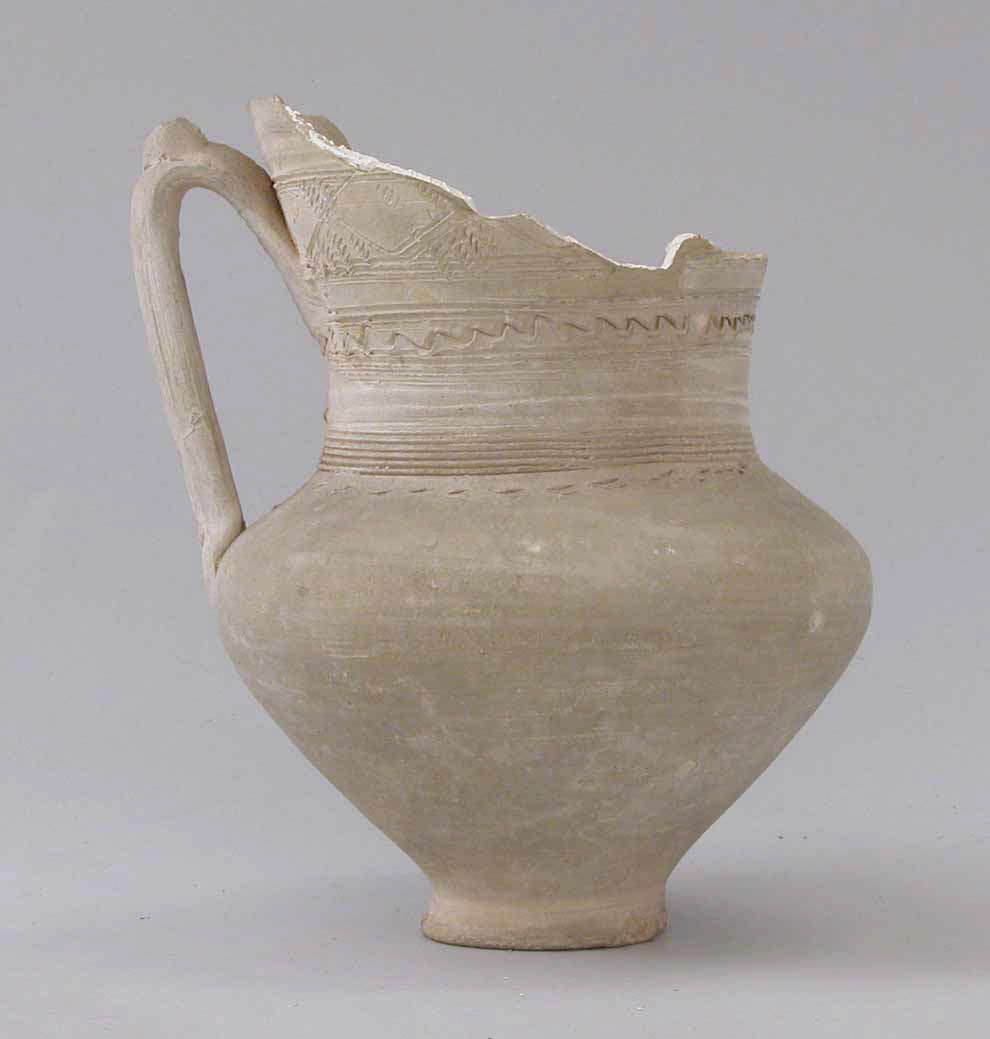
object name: jug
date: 801-900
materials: earthenware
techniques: incising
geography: iran